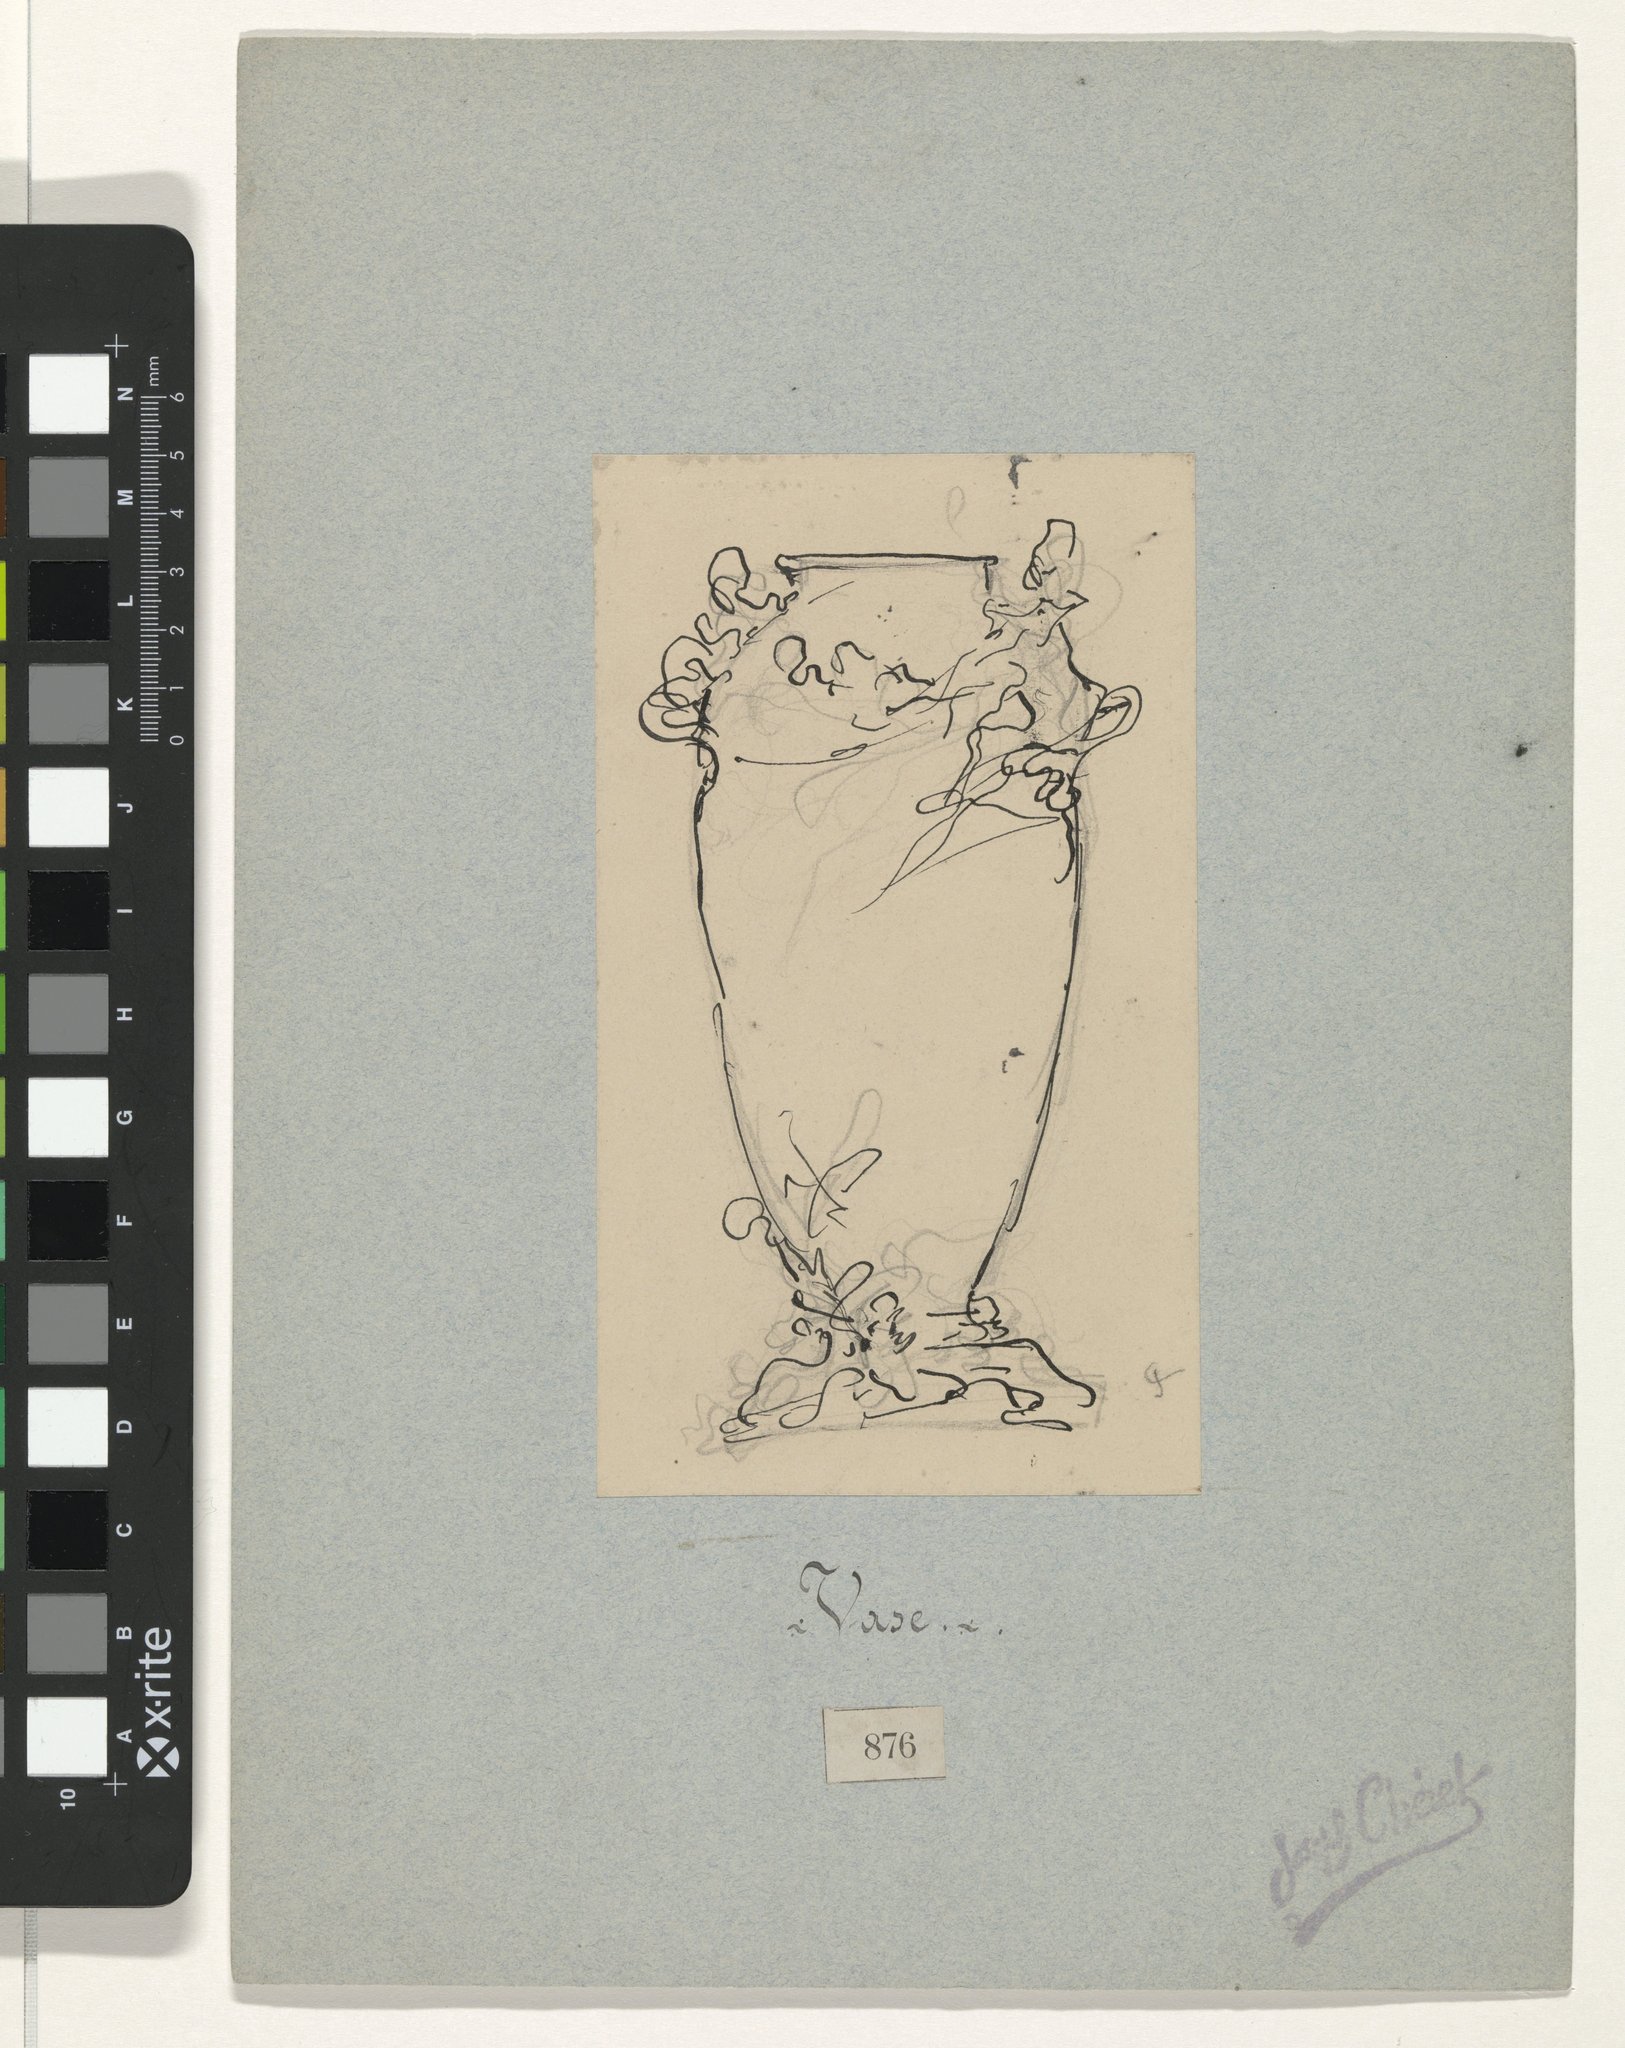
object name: design drawing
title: Vaas met figuren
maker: gustave joseph chéret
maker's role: sculptor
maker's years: 1838-1894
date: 1870-1894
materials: cardboard, graphite, ink, paper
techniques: pen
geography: paris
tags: containers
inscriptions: monogram: ‘JC’, label: ‘876’, inscription: ‘500’, workshop stamp: ‘Joseph Chéret’, inscription: ‘Vase’